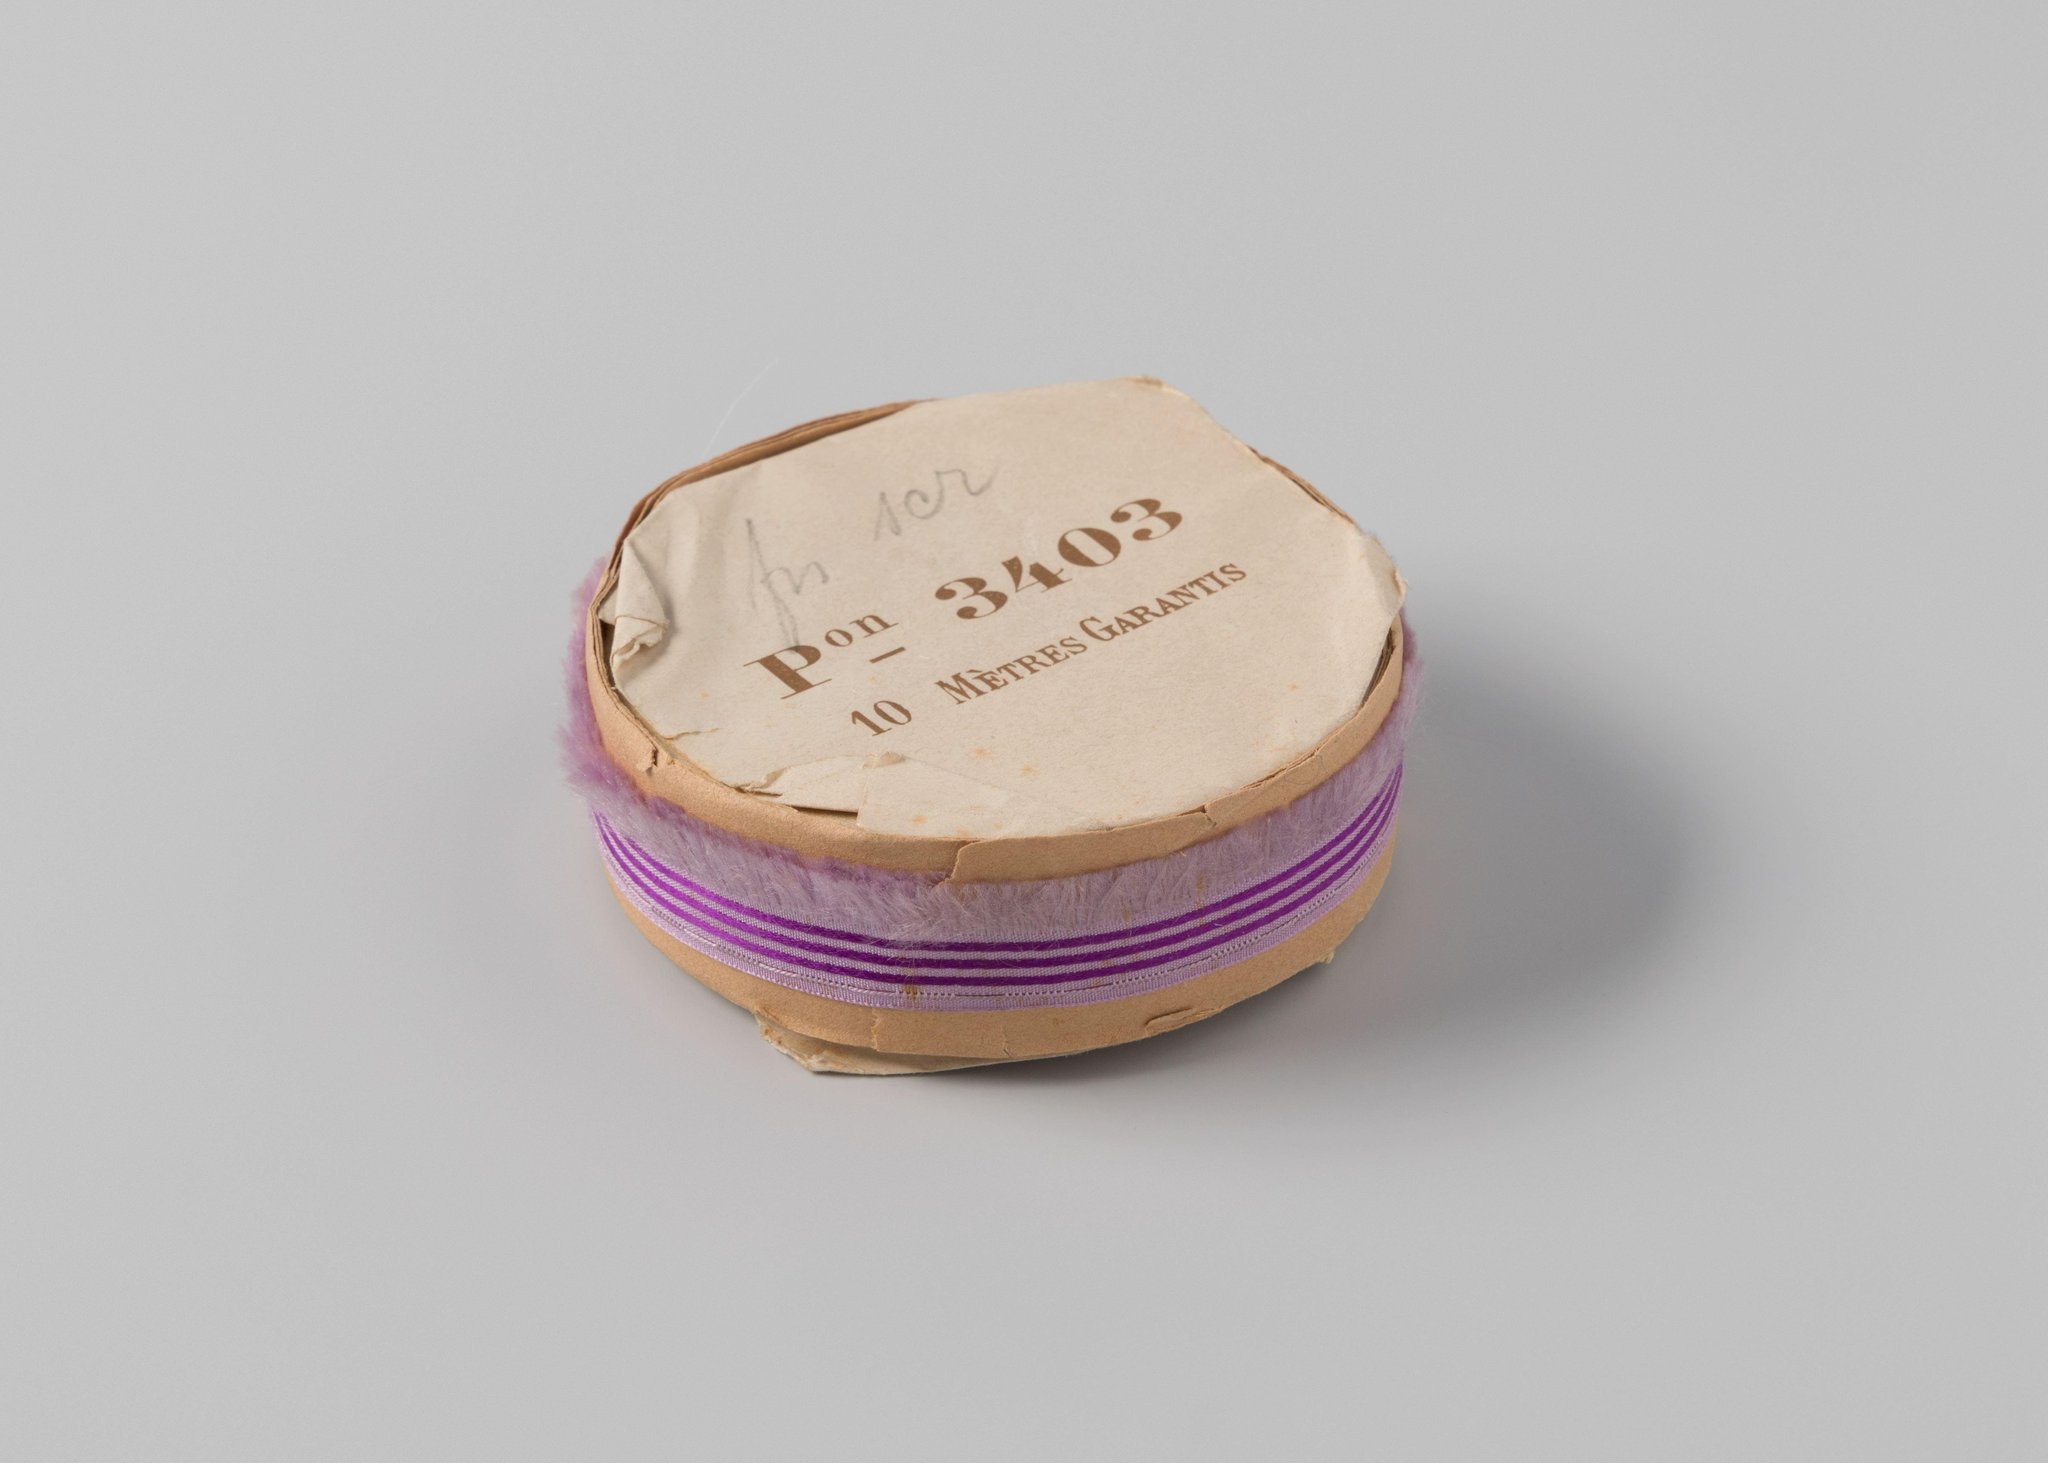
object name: braid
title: Rol met lila lint met één gerafelde zijde en drie paarse horizontale strepen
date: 1935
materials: cardboard, paper, textile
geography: nijmegen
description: Rol met lila lint met één gerafelde zijde en drie paarse horizontale strepen.